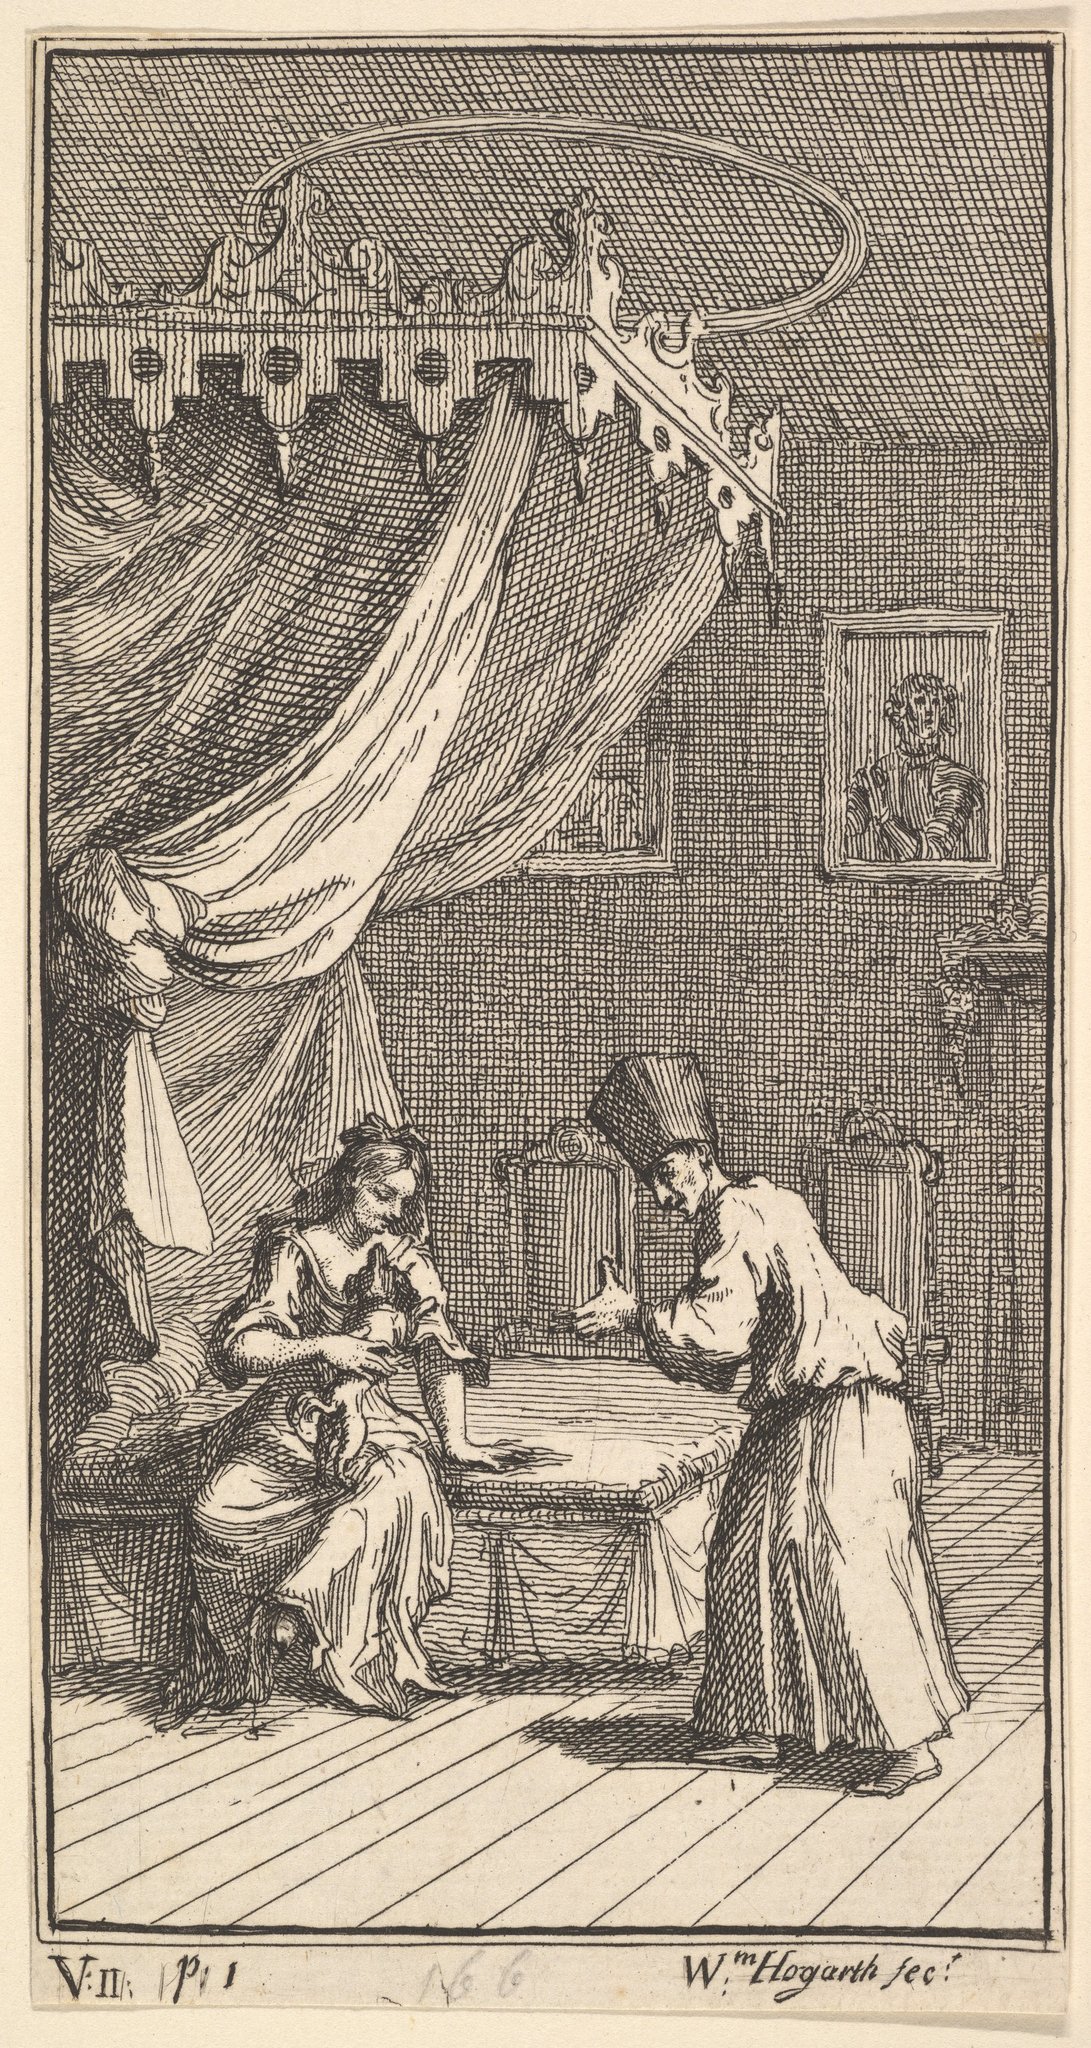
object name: print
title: The New Metamorphosis, Plate 5: Fantasio, Transformed into a Lapdog, in the with Donna Theresa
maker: william hogarth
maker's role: artist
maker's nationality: british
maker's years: 1697-1764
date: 1724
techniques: engraving, etching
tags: bedrooms,men,women,dogs